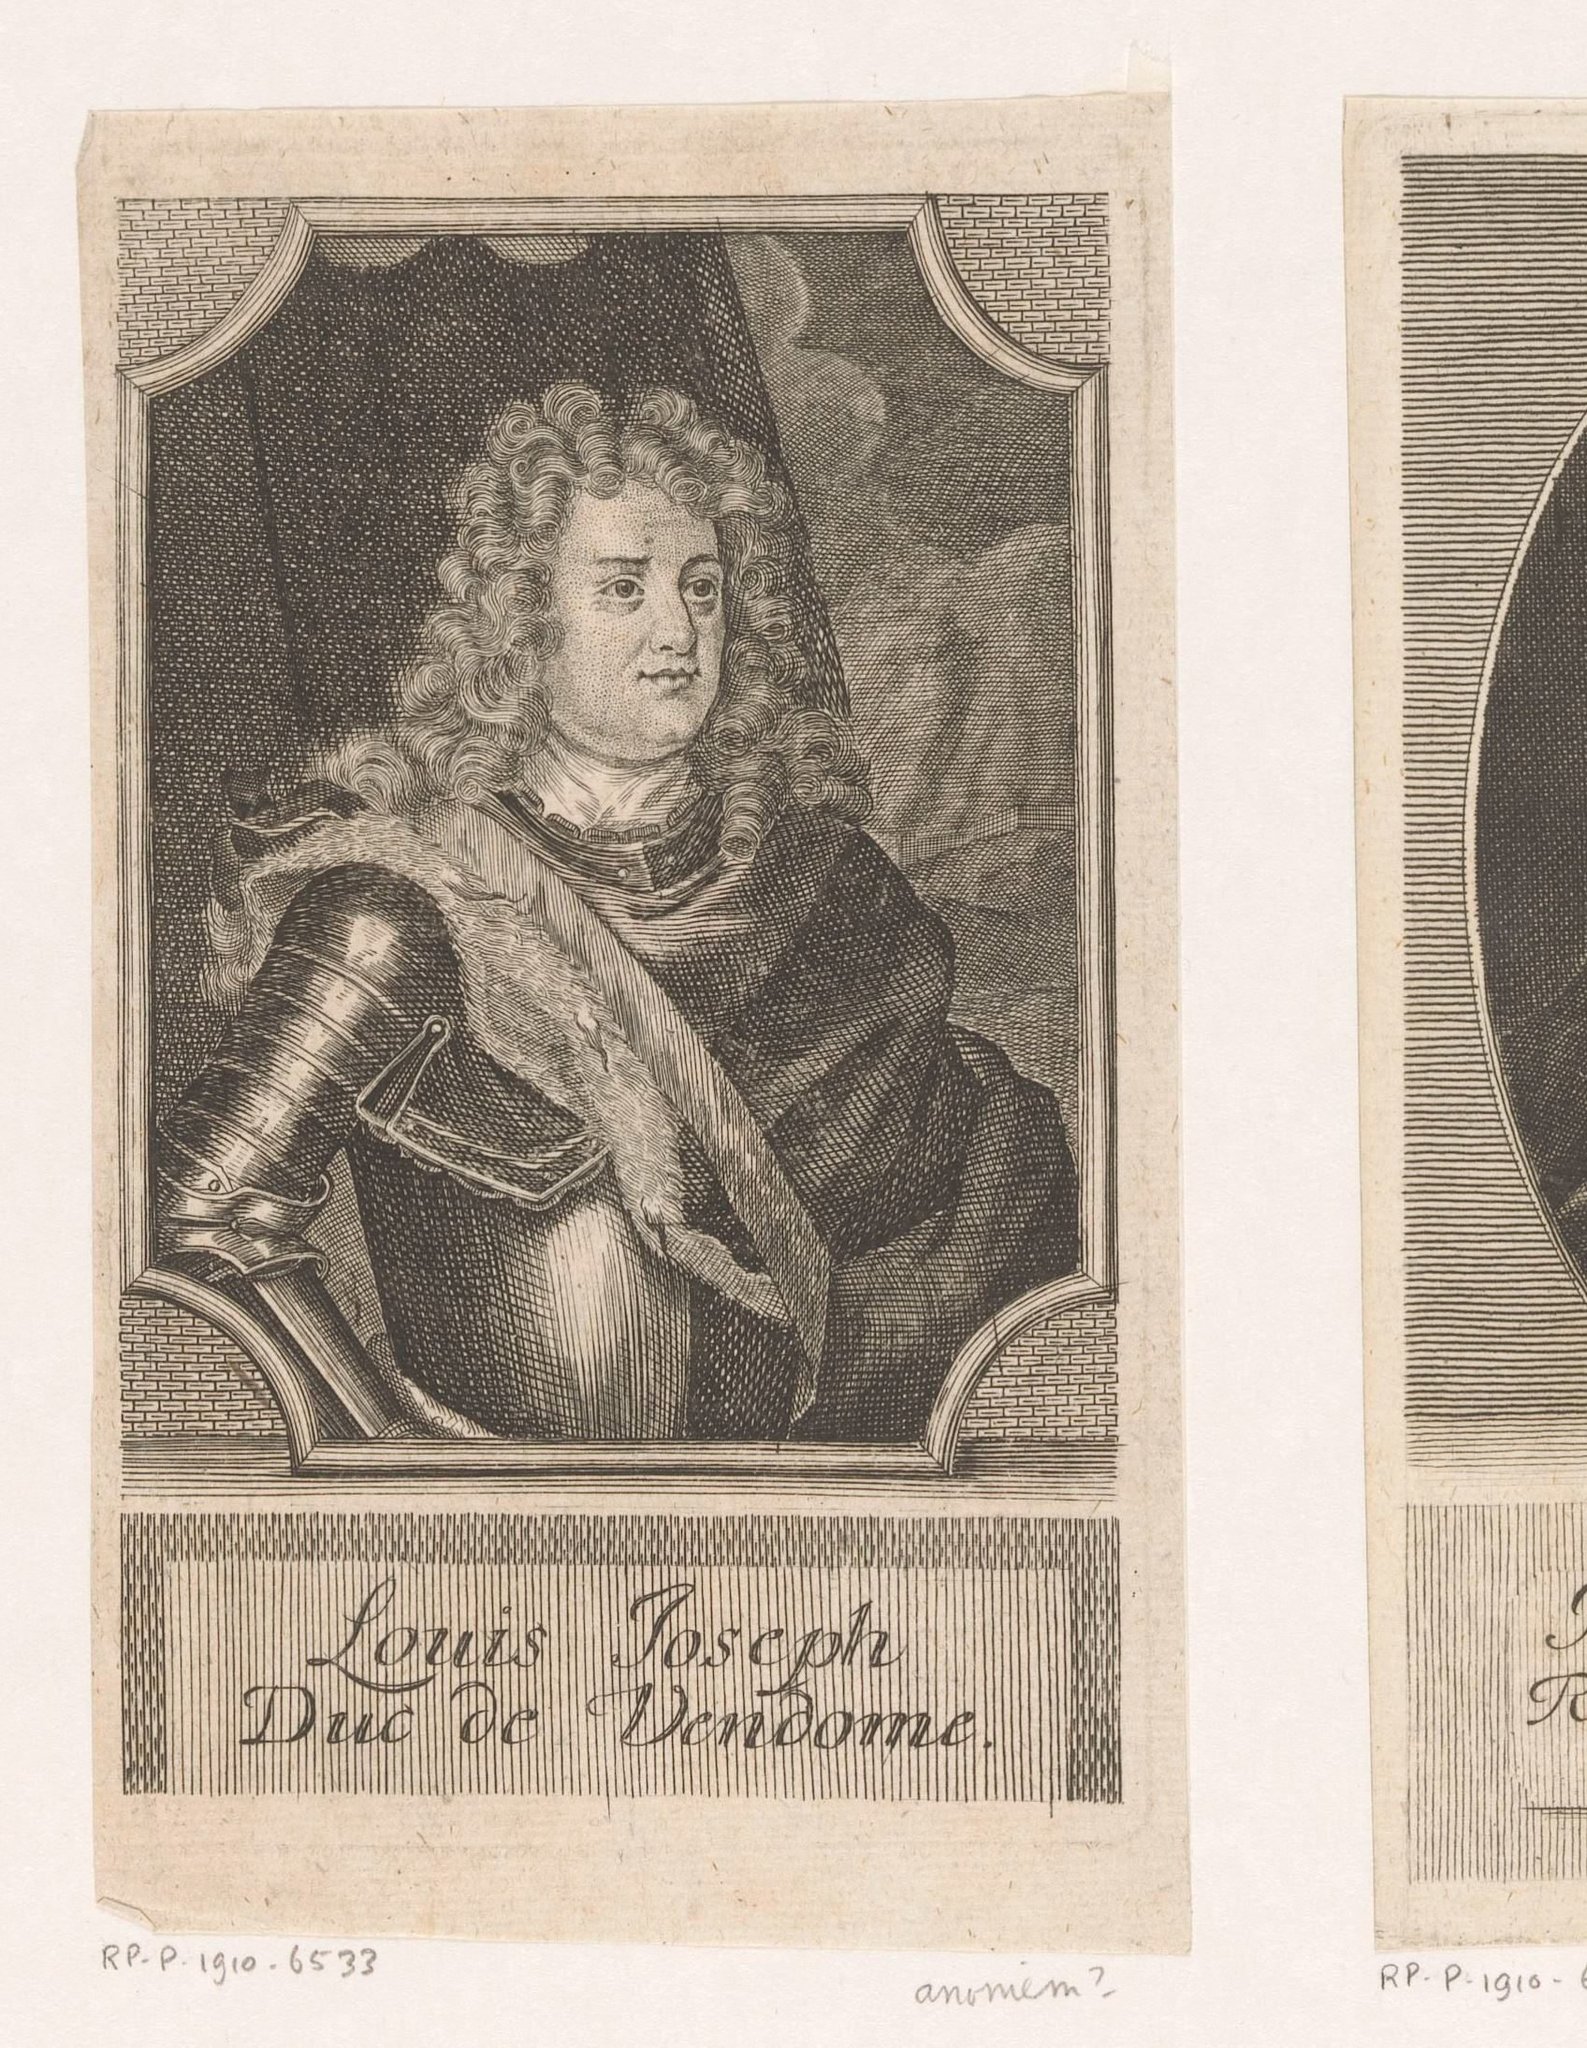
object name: print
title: Portret van Louis Joseph de Bourbon-Vendôme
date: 1680-1733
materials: paper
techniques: engraving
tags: paris, armour, historical persons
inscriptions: collector's mark: Lugt 2228